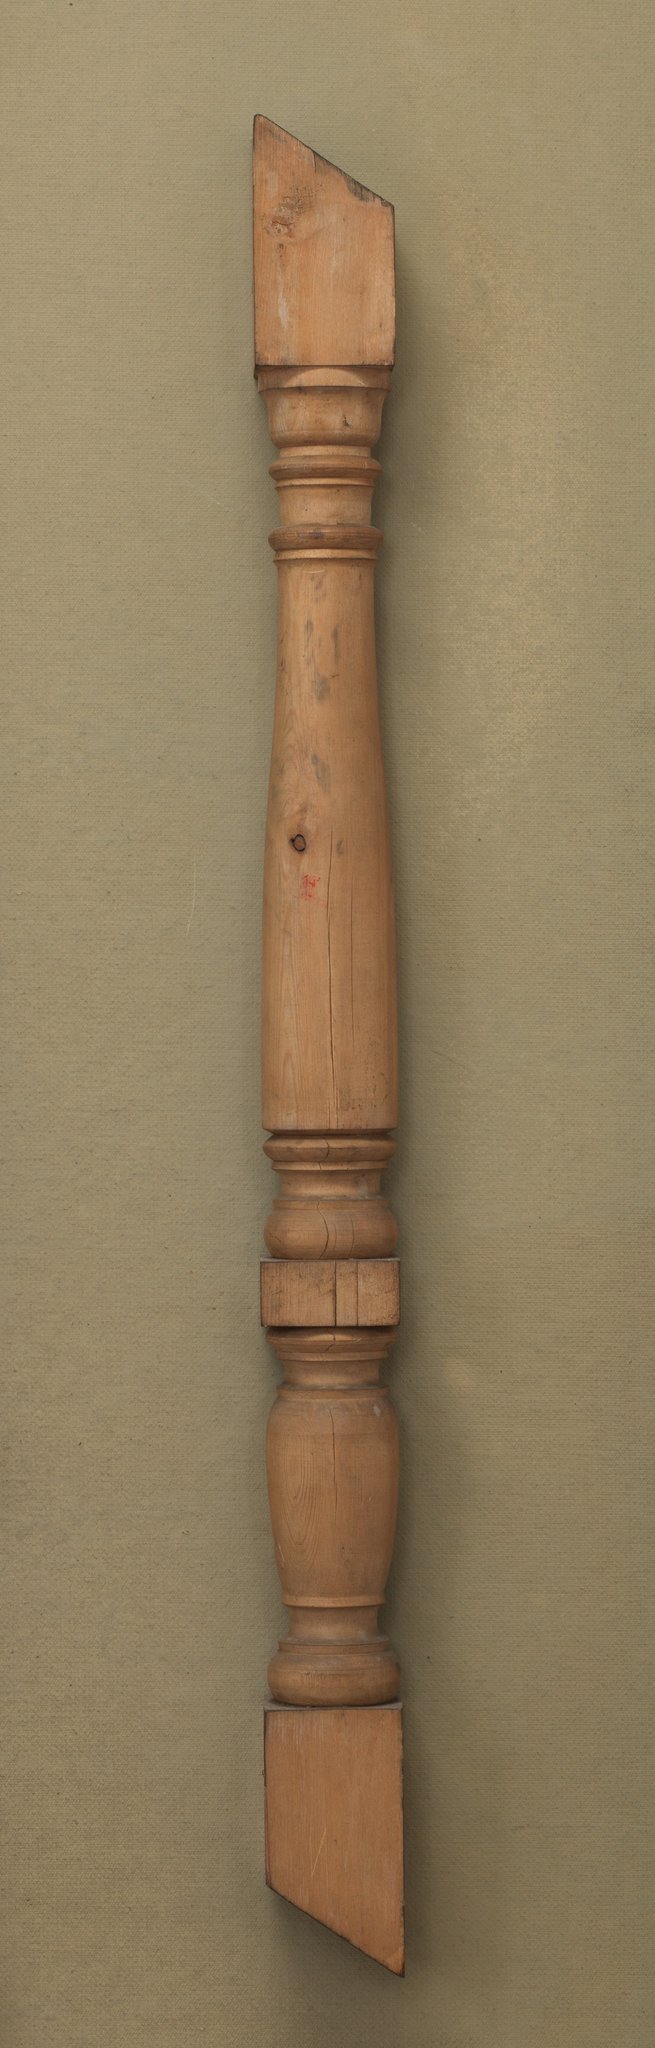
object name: baluster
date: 1734-1766